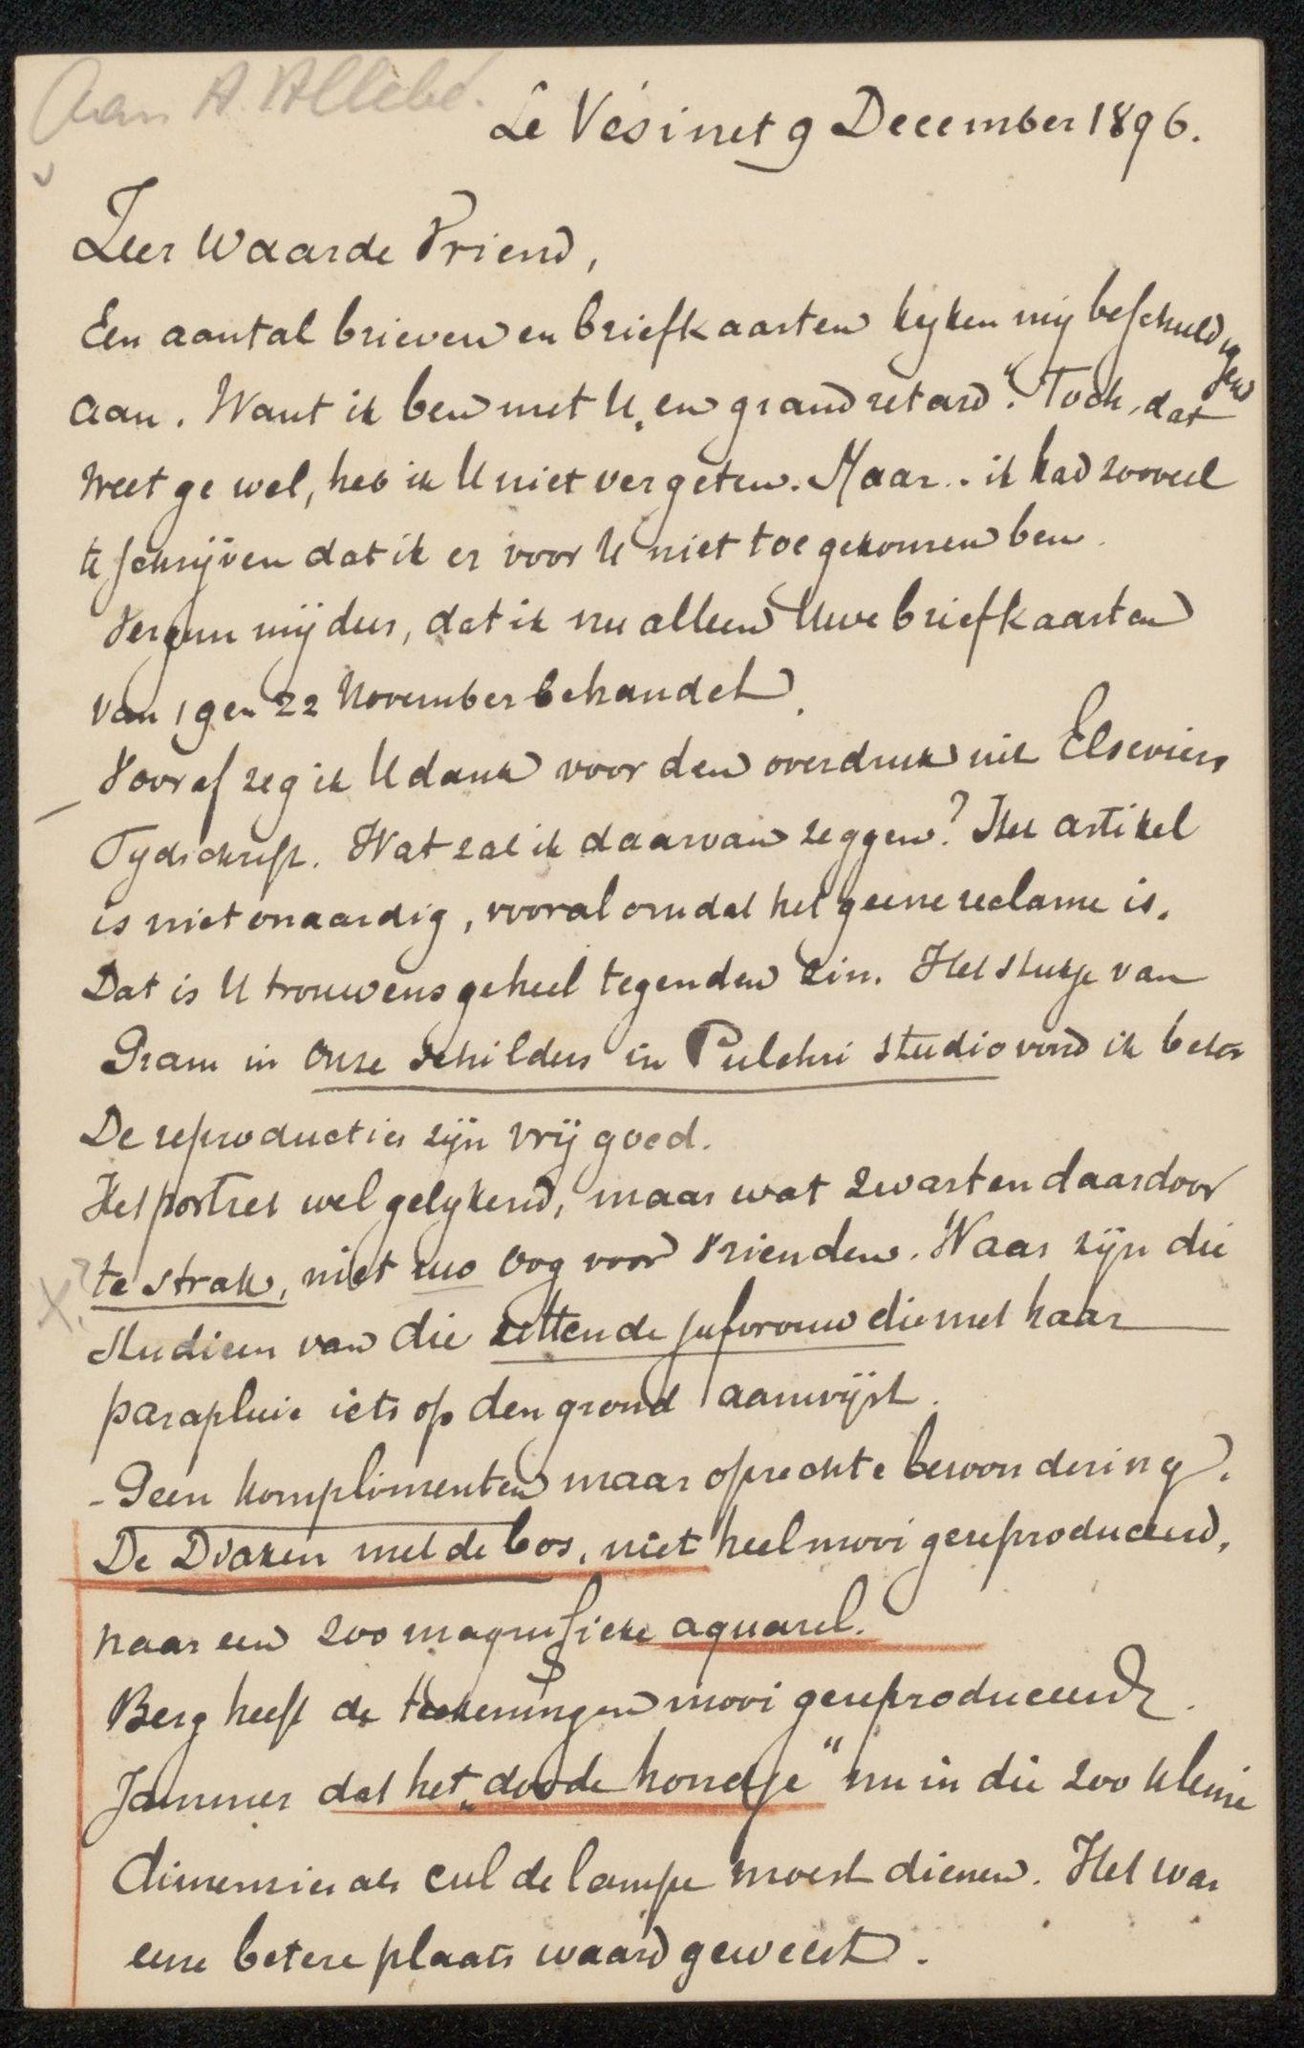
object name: letter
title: Brief aan August Allebé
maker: daniël franken dzn.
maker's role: bankier, kunsthistoricus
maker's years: 1838-1898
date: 1896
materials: ink, paper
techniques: pen, writing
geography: le vésinet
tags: paris, print maker, draughtsman, adolphe mouilleron, august allebé, johan gram, drawing, anonymous historical person portrayed, painting (including book-illumination, miniature-painting), art collecting, printed matter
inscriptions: collector's mark: ‘RPK’